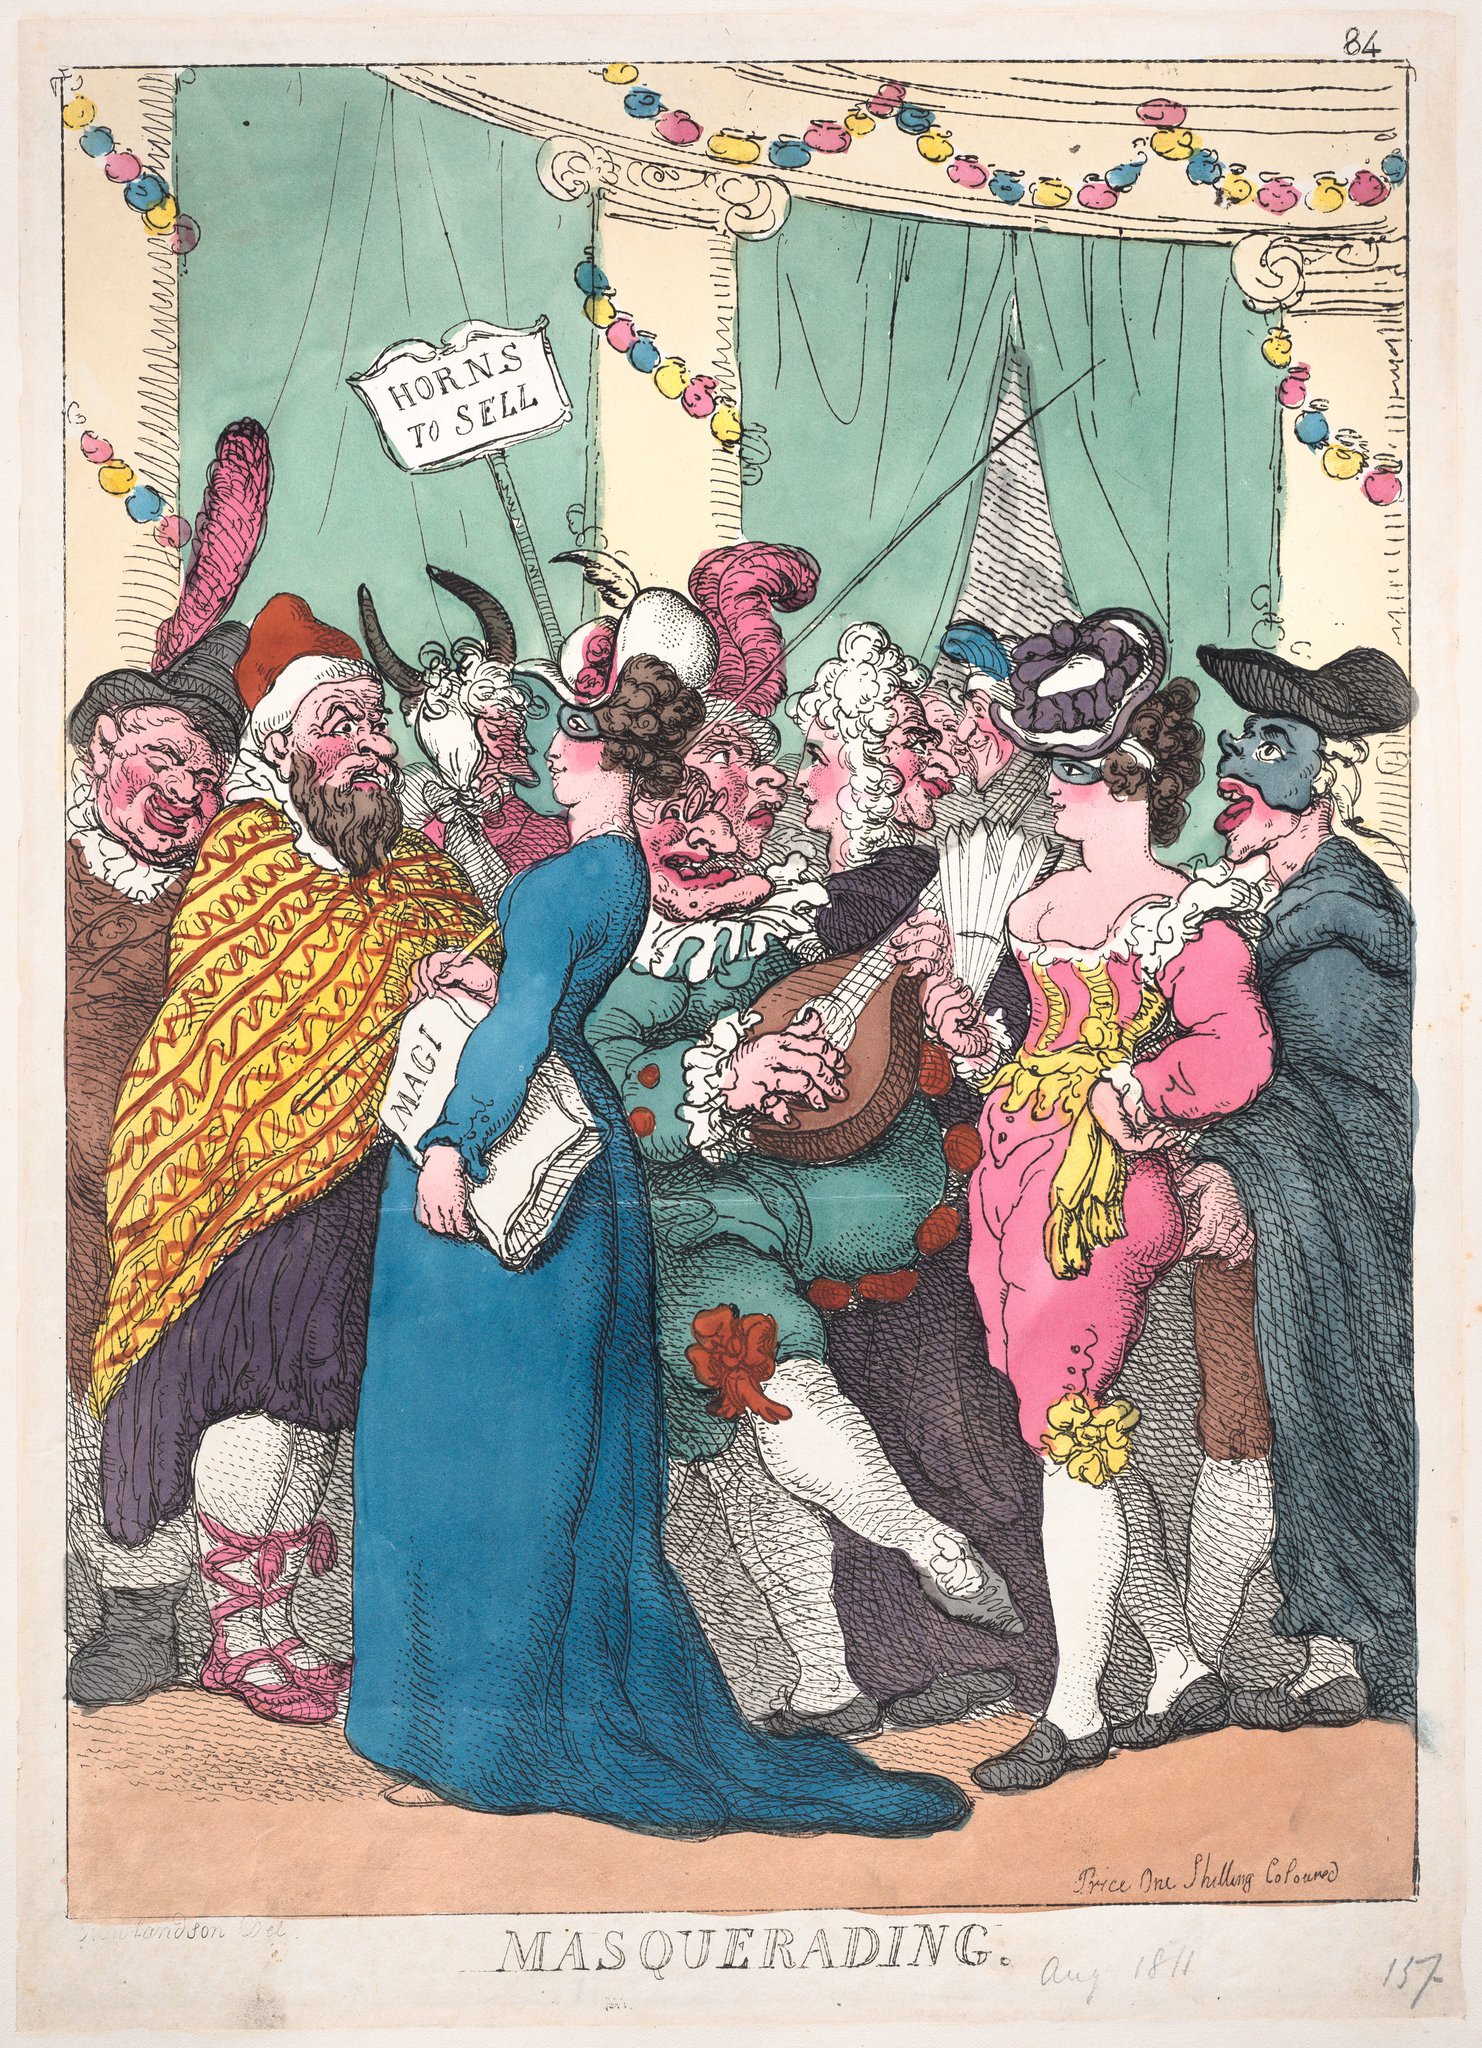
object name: print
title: Masquerading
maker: thomas rowlandson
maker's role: artist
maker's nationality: british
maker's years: 1757-1827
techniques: etching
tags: satire,men,women